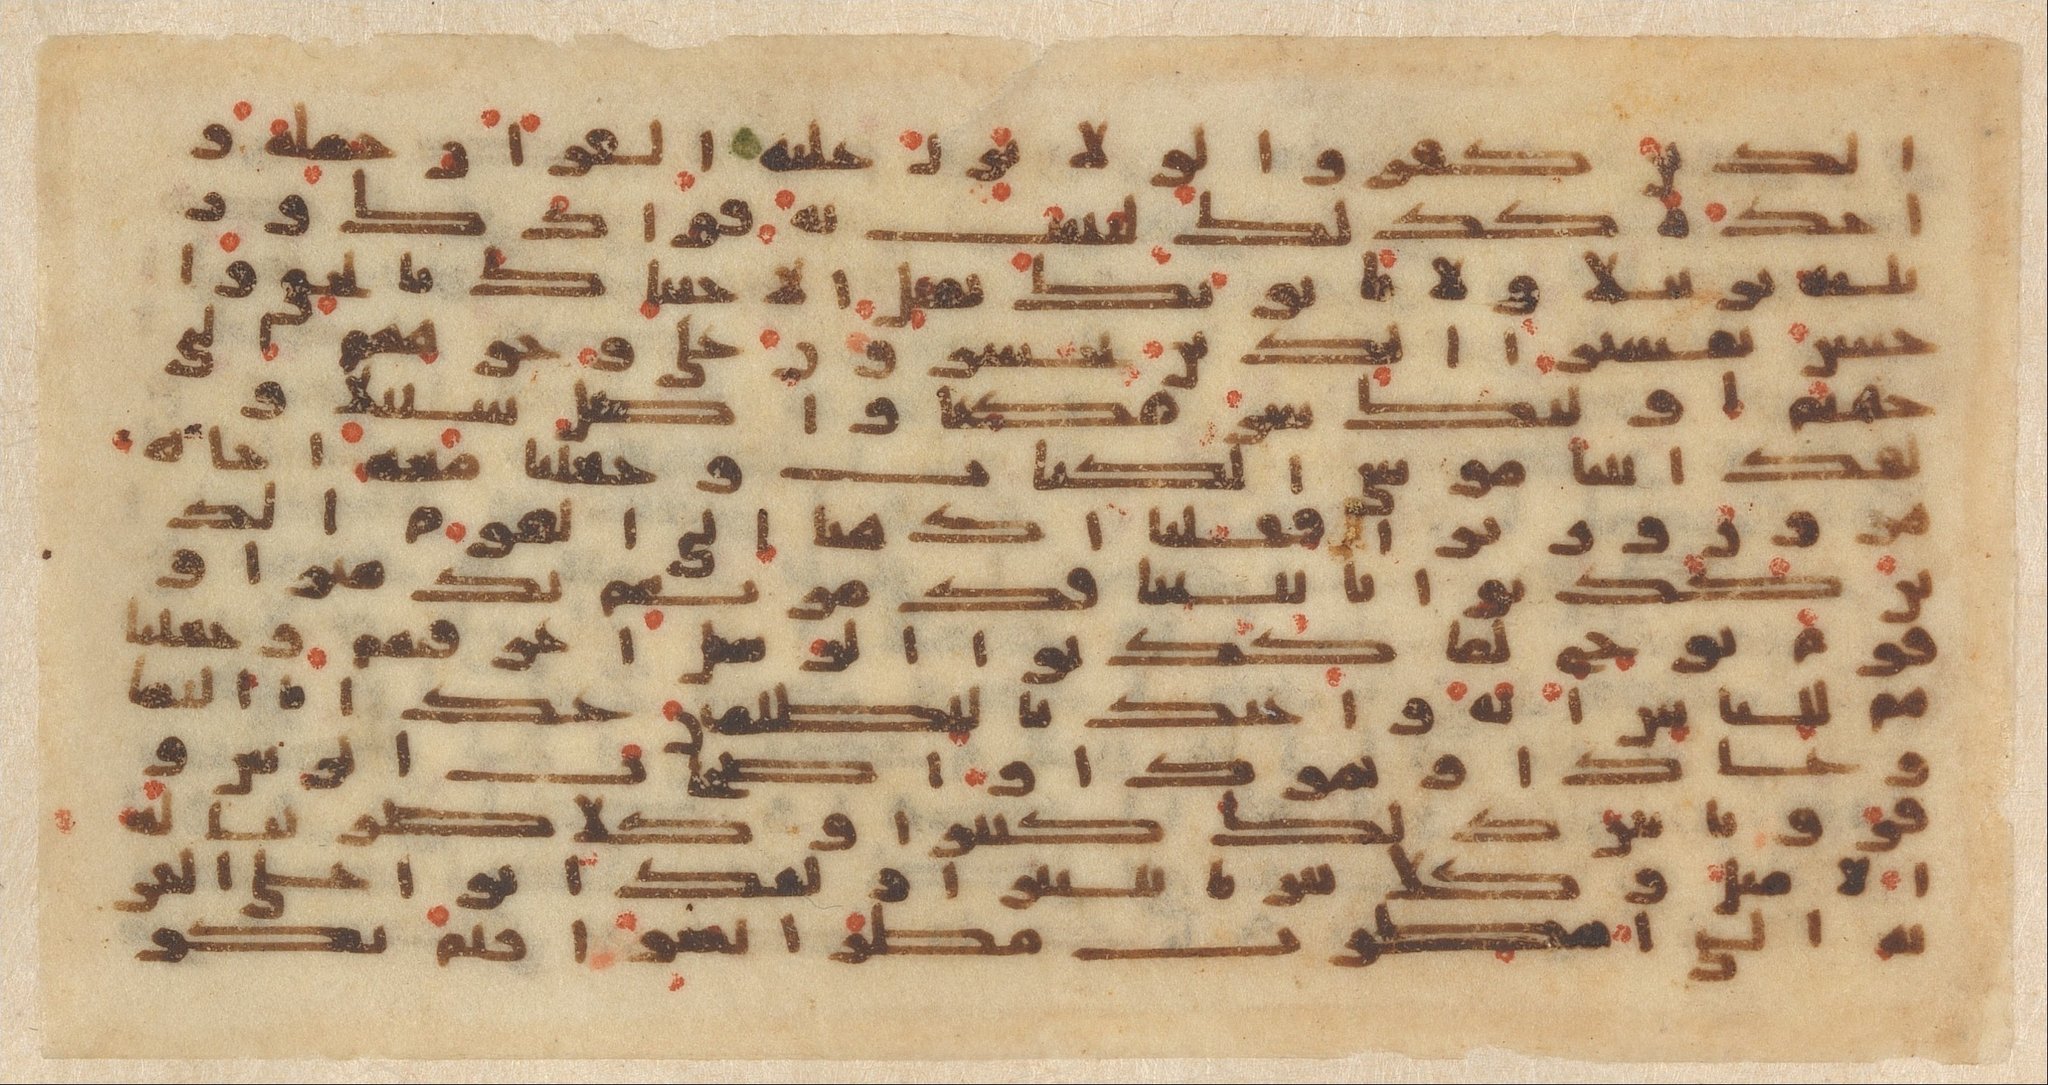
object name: folio from a non illustrated manuscript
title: Folio from a Qur'an Manuscript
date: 801-900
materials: gold, ink, parchment, watercolor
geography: central islamic lands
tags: arabic,qur'an,calligraphy